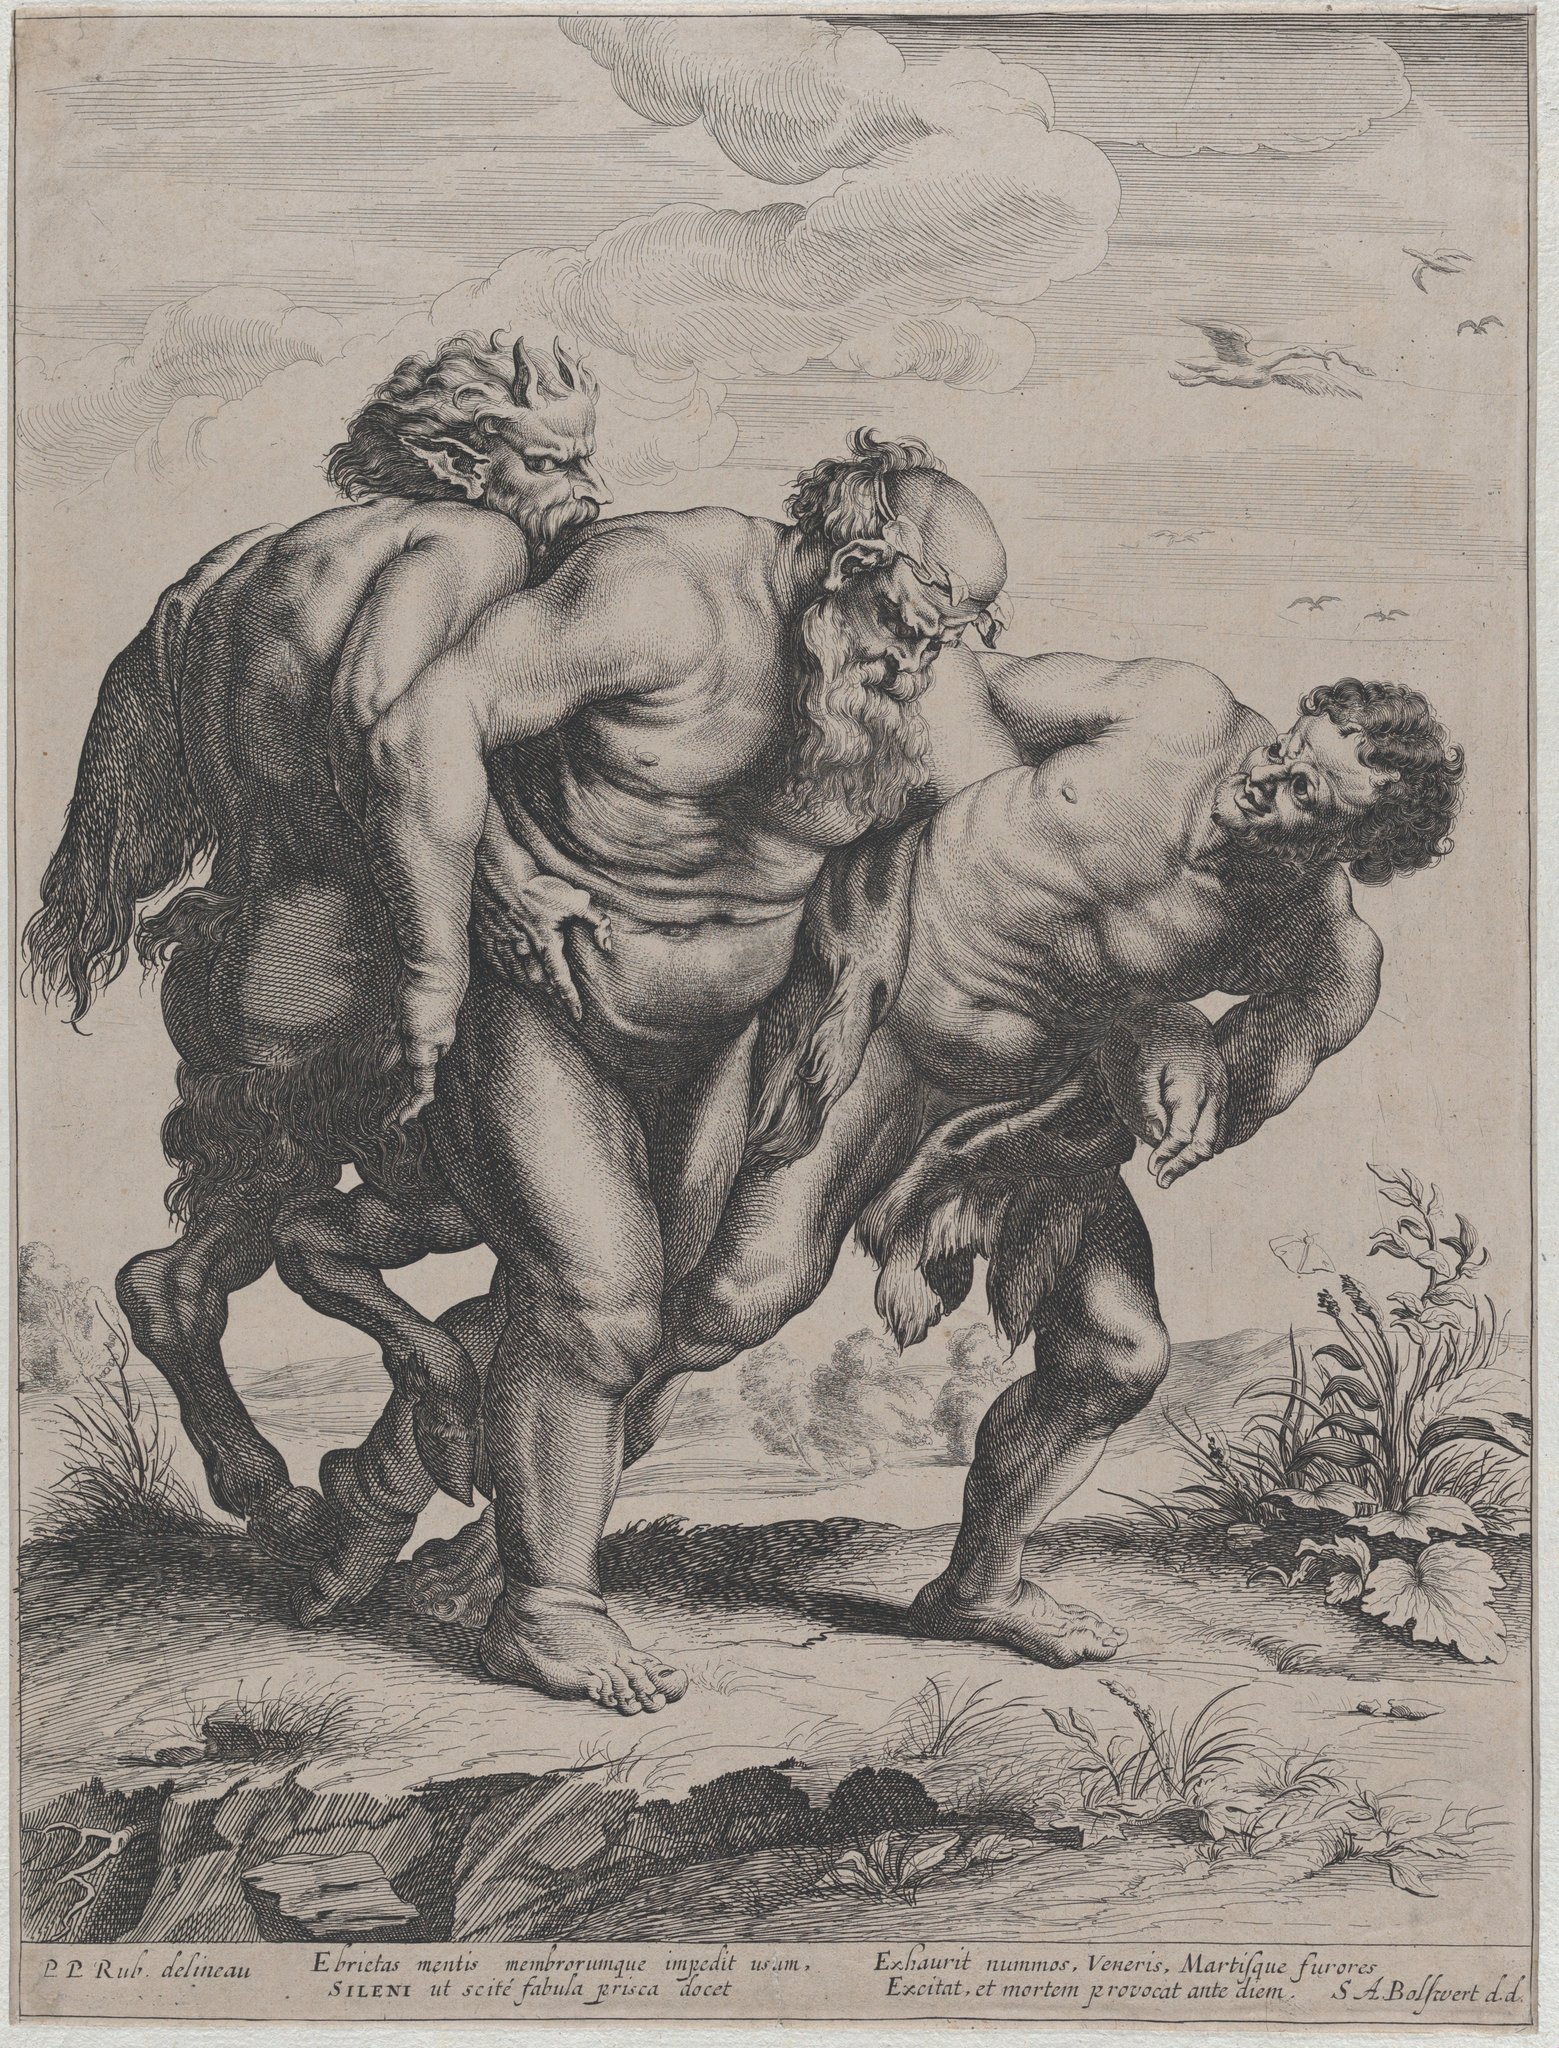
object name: print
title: The drunken Silenus, supported by a satyr and a faun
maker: schelte adams à bolswert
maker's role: artist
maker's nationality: dutch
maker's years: 1581-1659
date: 1625-1659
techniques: engraving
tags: silenus,fauns,satyrs